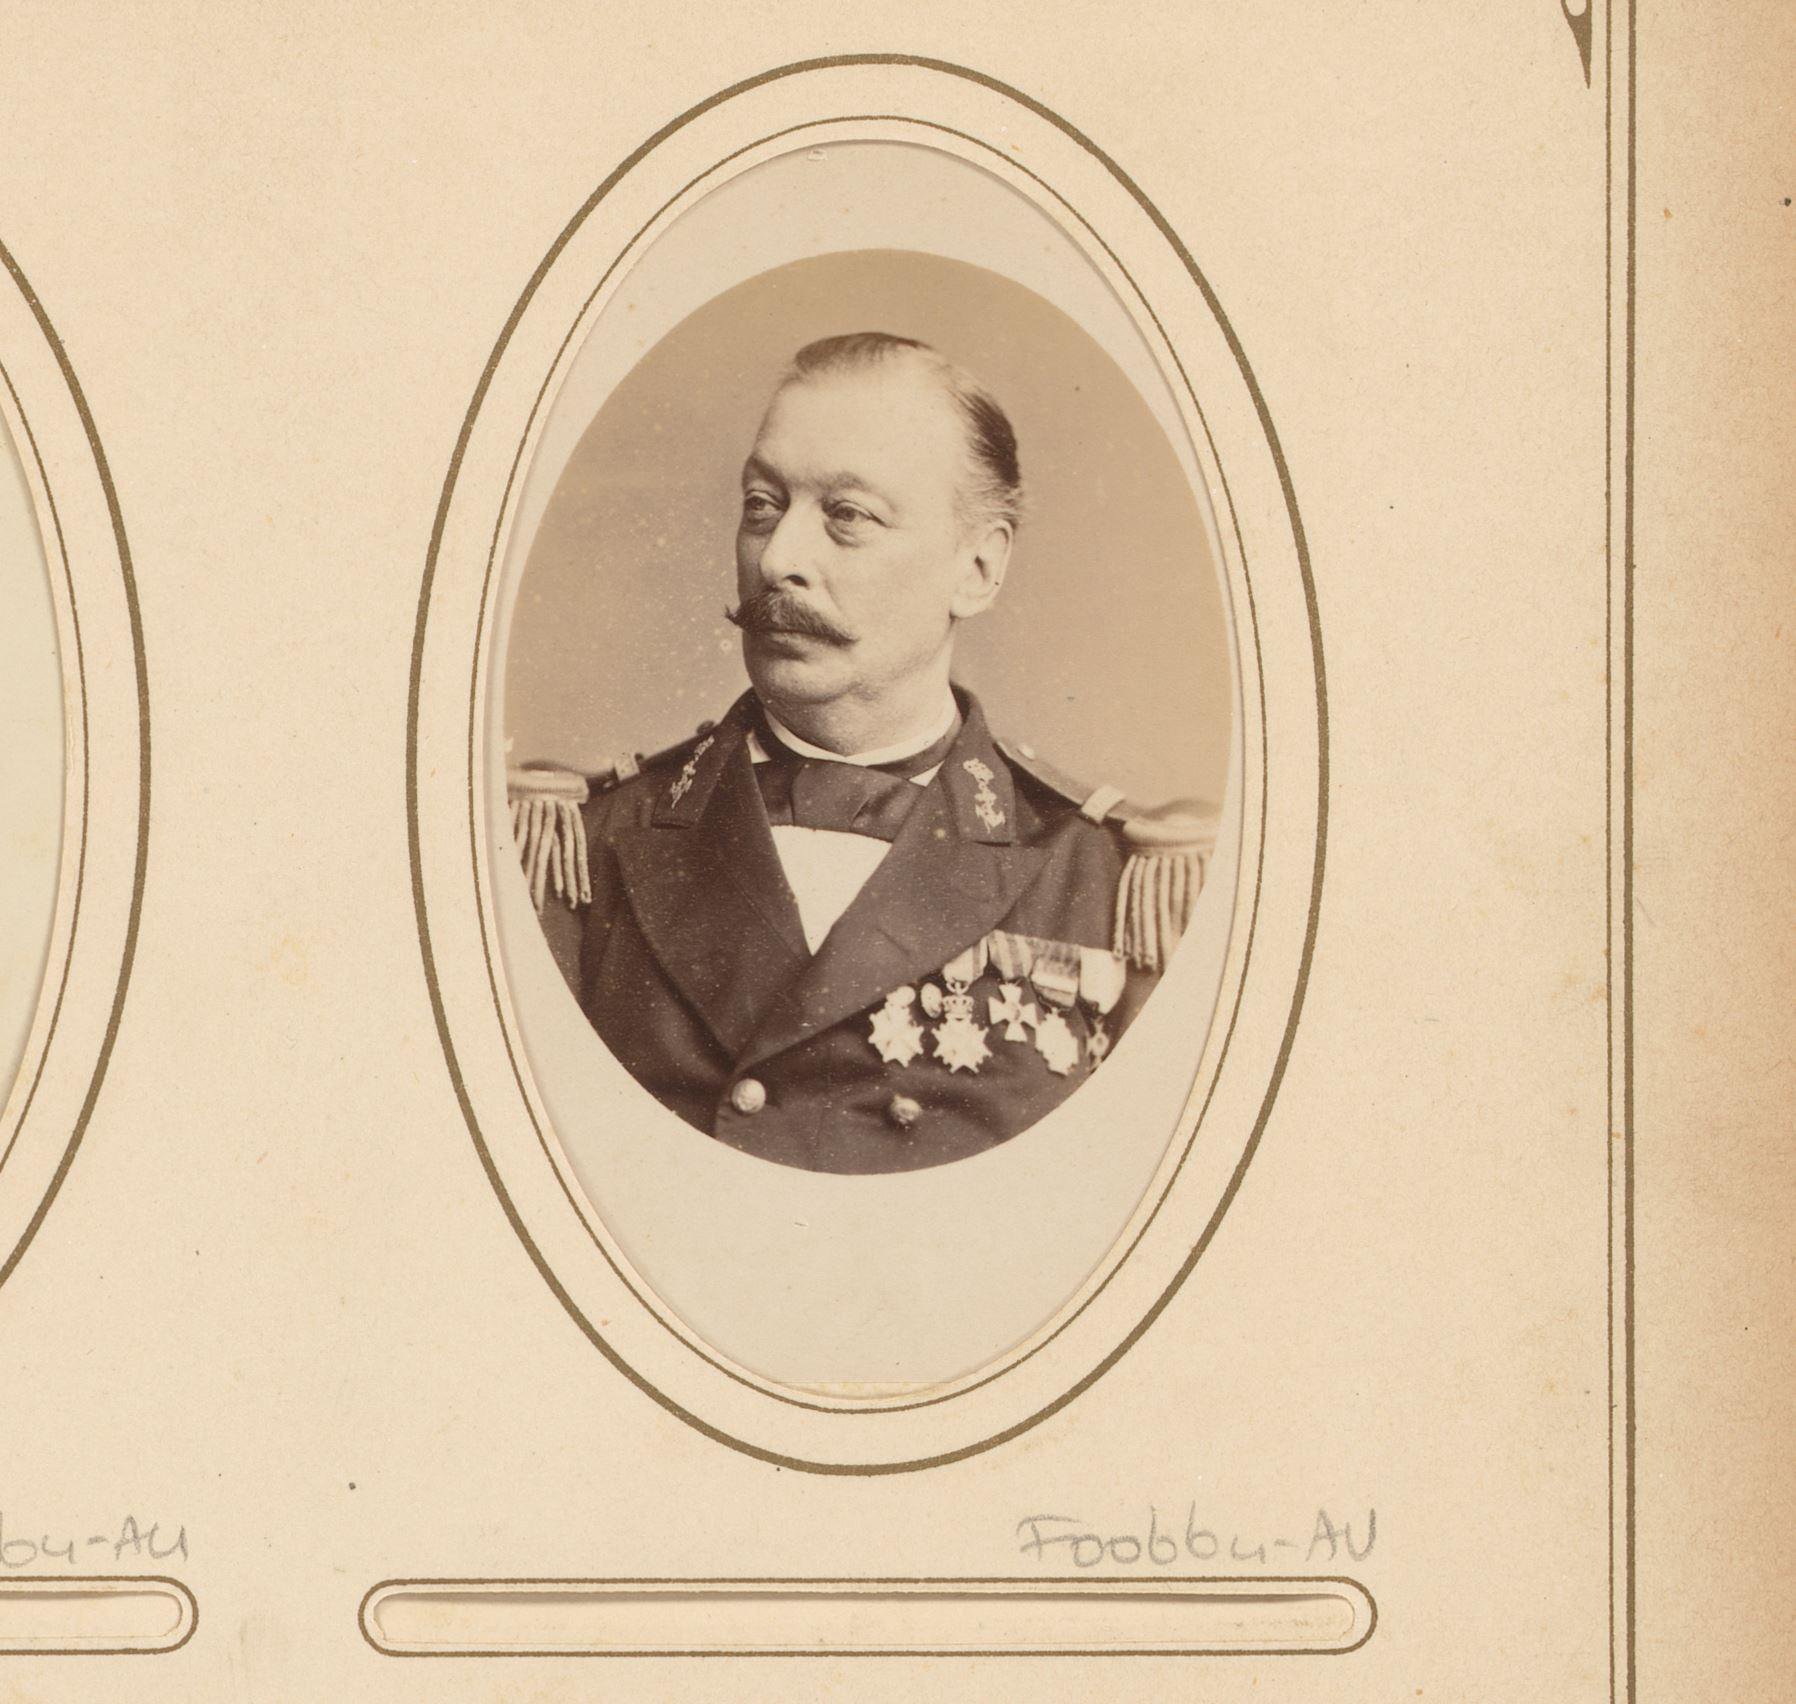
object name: photograph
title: Portret van jonkheer Marten Wilhelmus Bowier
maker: albert greiner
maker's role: fotograaf, fotostudio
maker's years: 1833-1890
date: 1861-1874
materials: cardboard, photographic support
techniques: albumen print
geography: amsterdam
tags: historical persons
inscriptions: annotation: ‘15e Nov. 1876 van den colonel eigenhandig ontv. [...] van zijn vertrek naar O.J.’, inscription: ‘A. Greiner/ photograf/ Nieuwendijk. L.89/ Amsterdam’